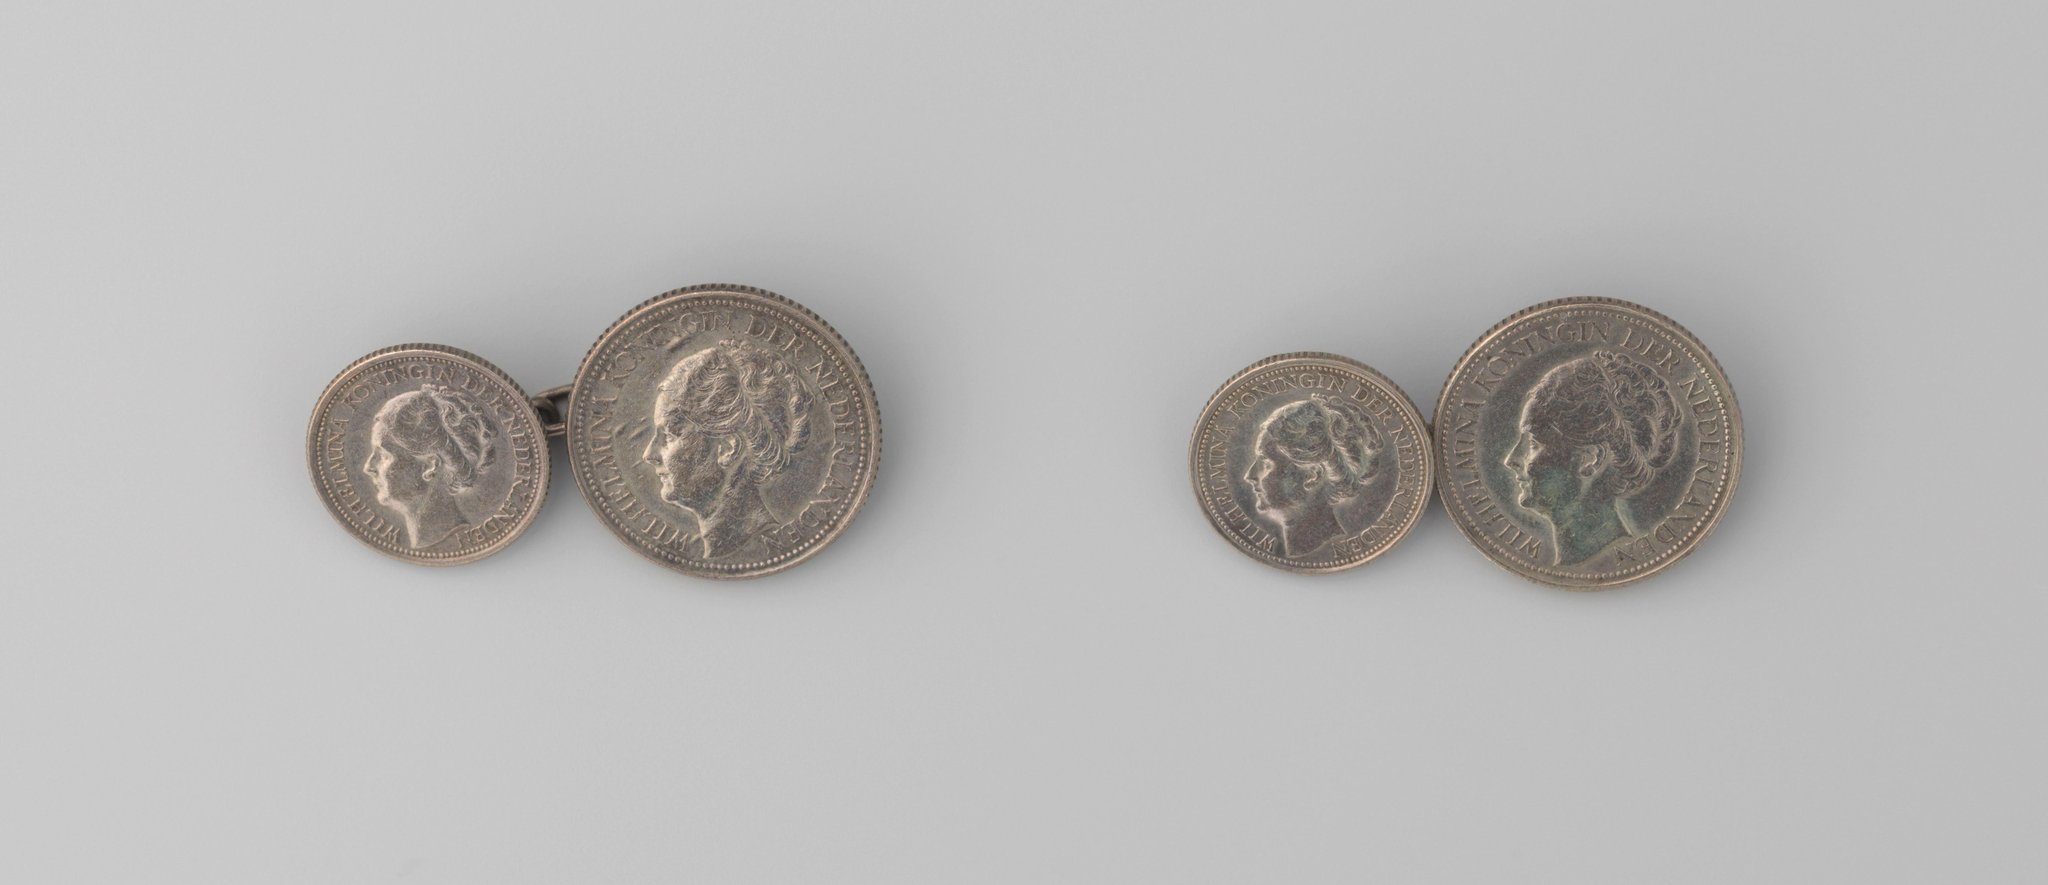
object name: cuff link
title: Manchetknoop van Nederlandse zilveren munten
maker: Anonymous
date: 1940-1950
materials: silver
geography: netherlands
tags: the hague, print maker, wilhelmina of the netherlands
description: Manchetknoop van Nederlandse zilveren munten. De knoop bestaat uit een dubbeltje en een kwartje met de beeldenaar van Wilhelmina. De munten zijn met elkaar verbonden door een ketting.